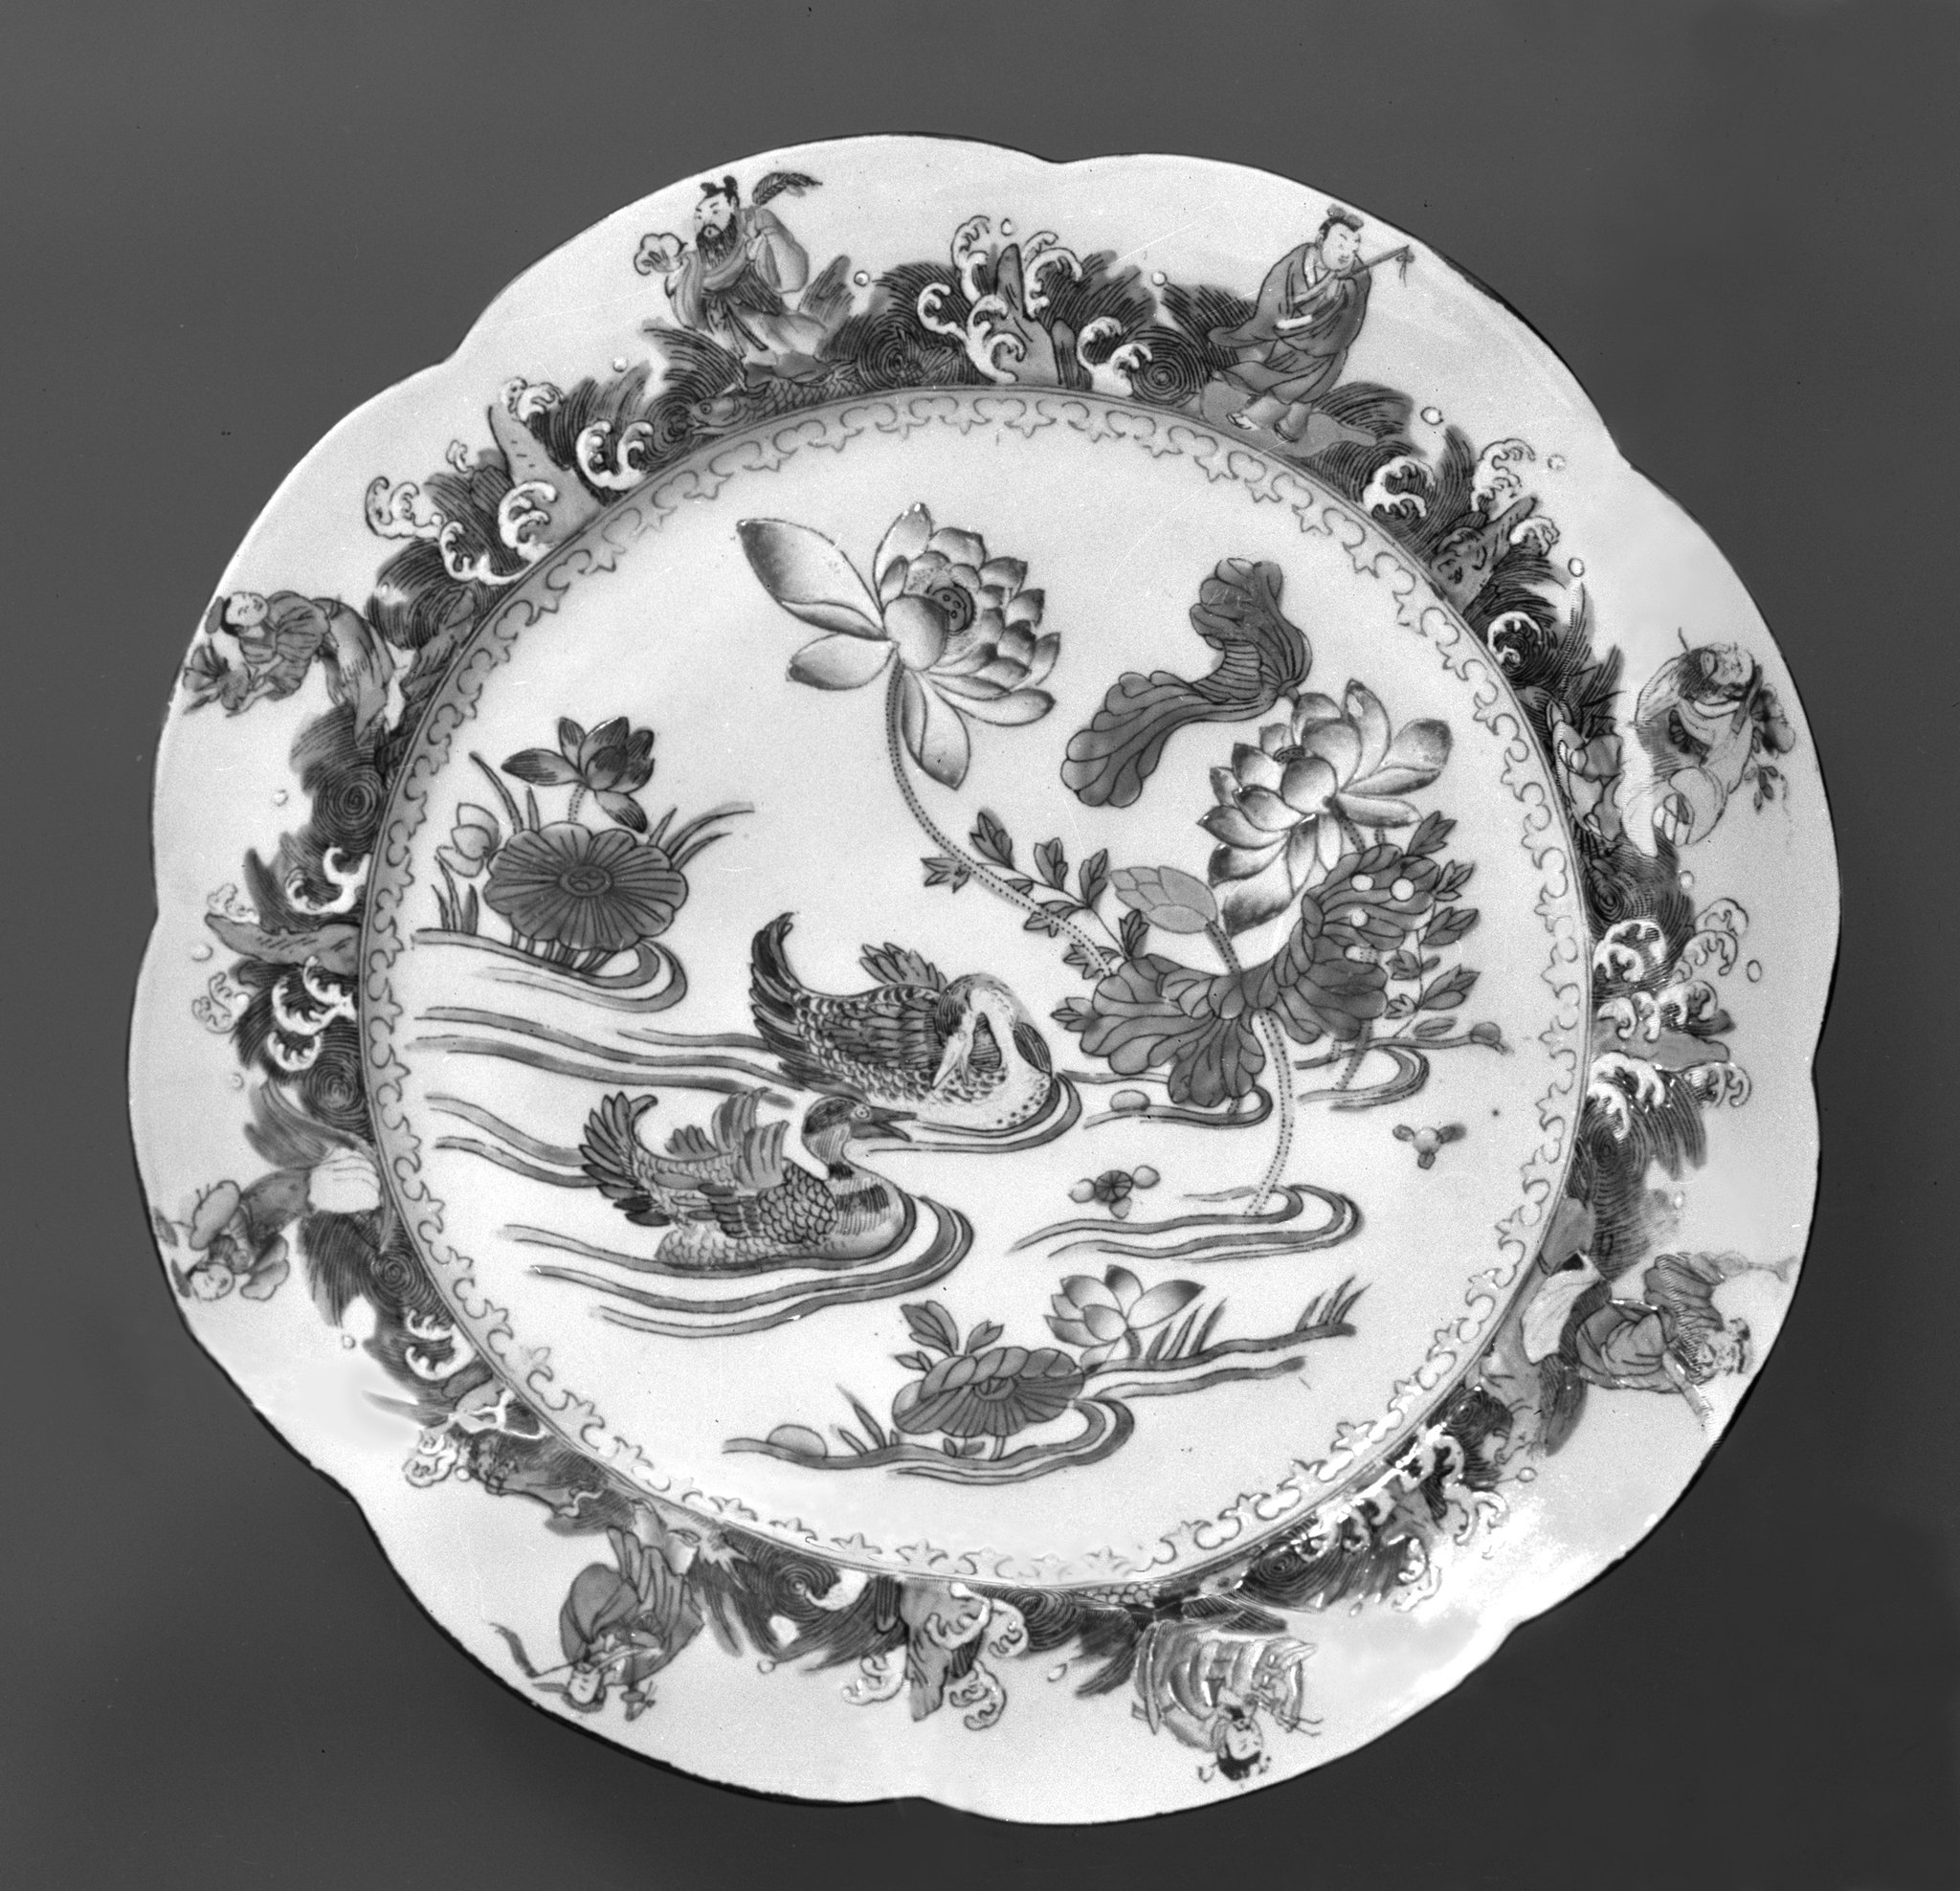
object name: plate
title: Plate with symbols of the Eight Immortals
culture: chinese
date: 1767-1800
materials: enamel, porcelain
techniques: overglaze, painting, polychrome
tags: ducks,men,lotuses